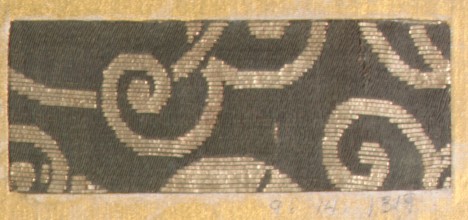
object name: piece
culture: japanese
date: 1701-1900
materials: silk